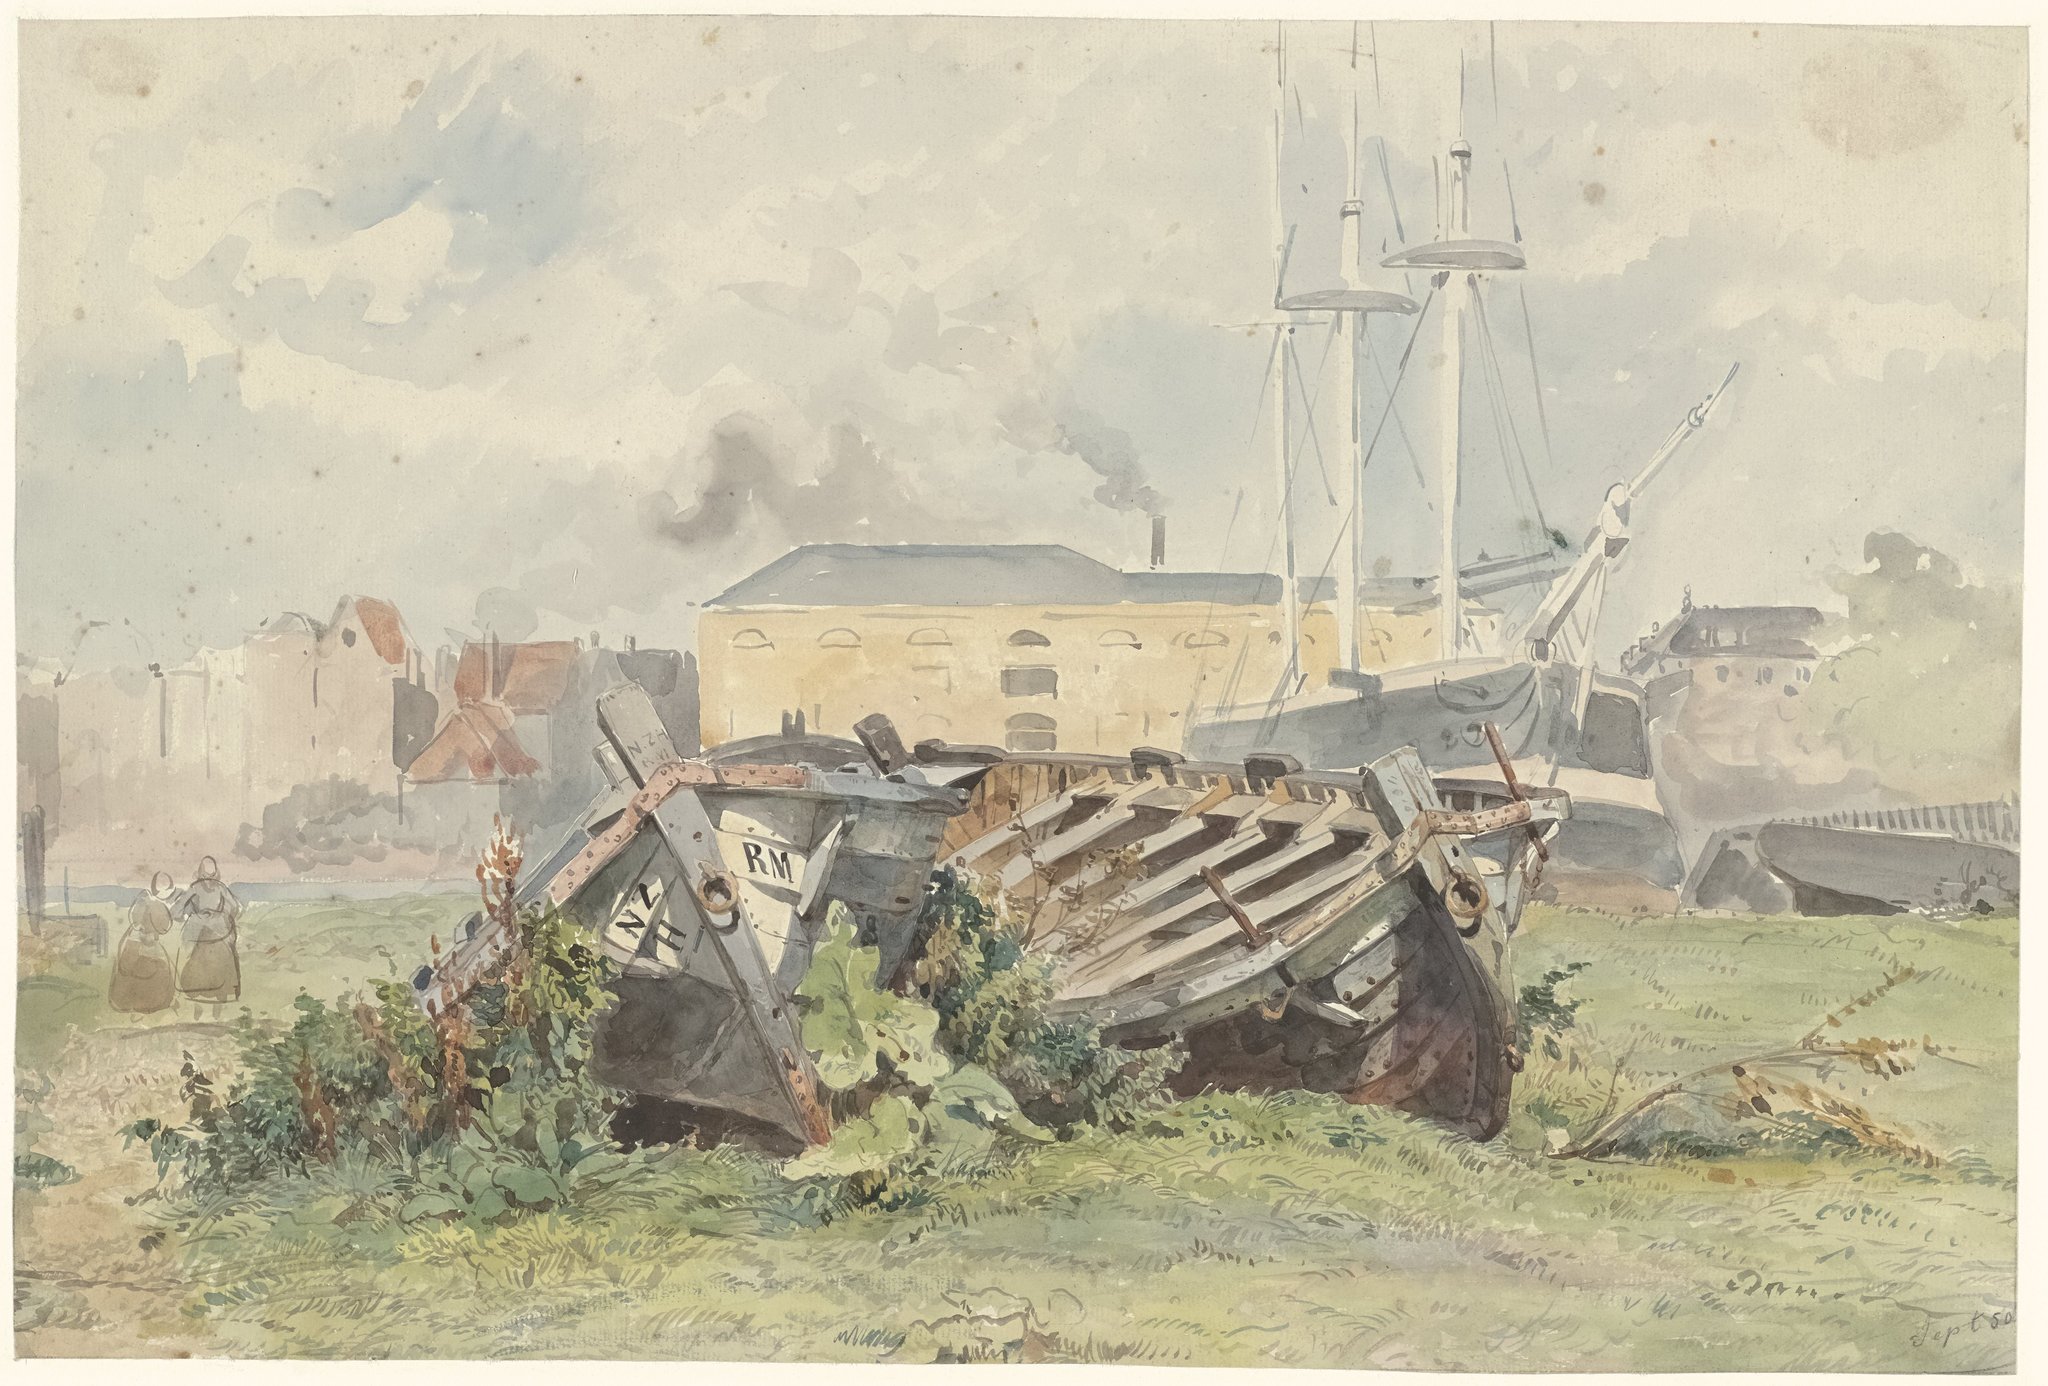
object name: drawing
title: Scheepswerf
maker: willem anthonie van deventer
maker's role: draughtsman, painter, print maker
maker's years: 1824-1893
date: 1809-1850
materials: paper, pencil, watercolor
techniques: brush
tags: pier, quay, wharf